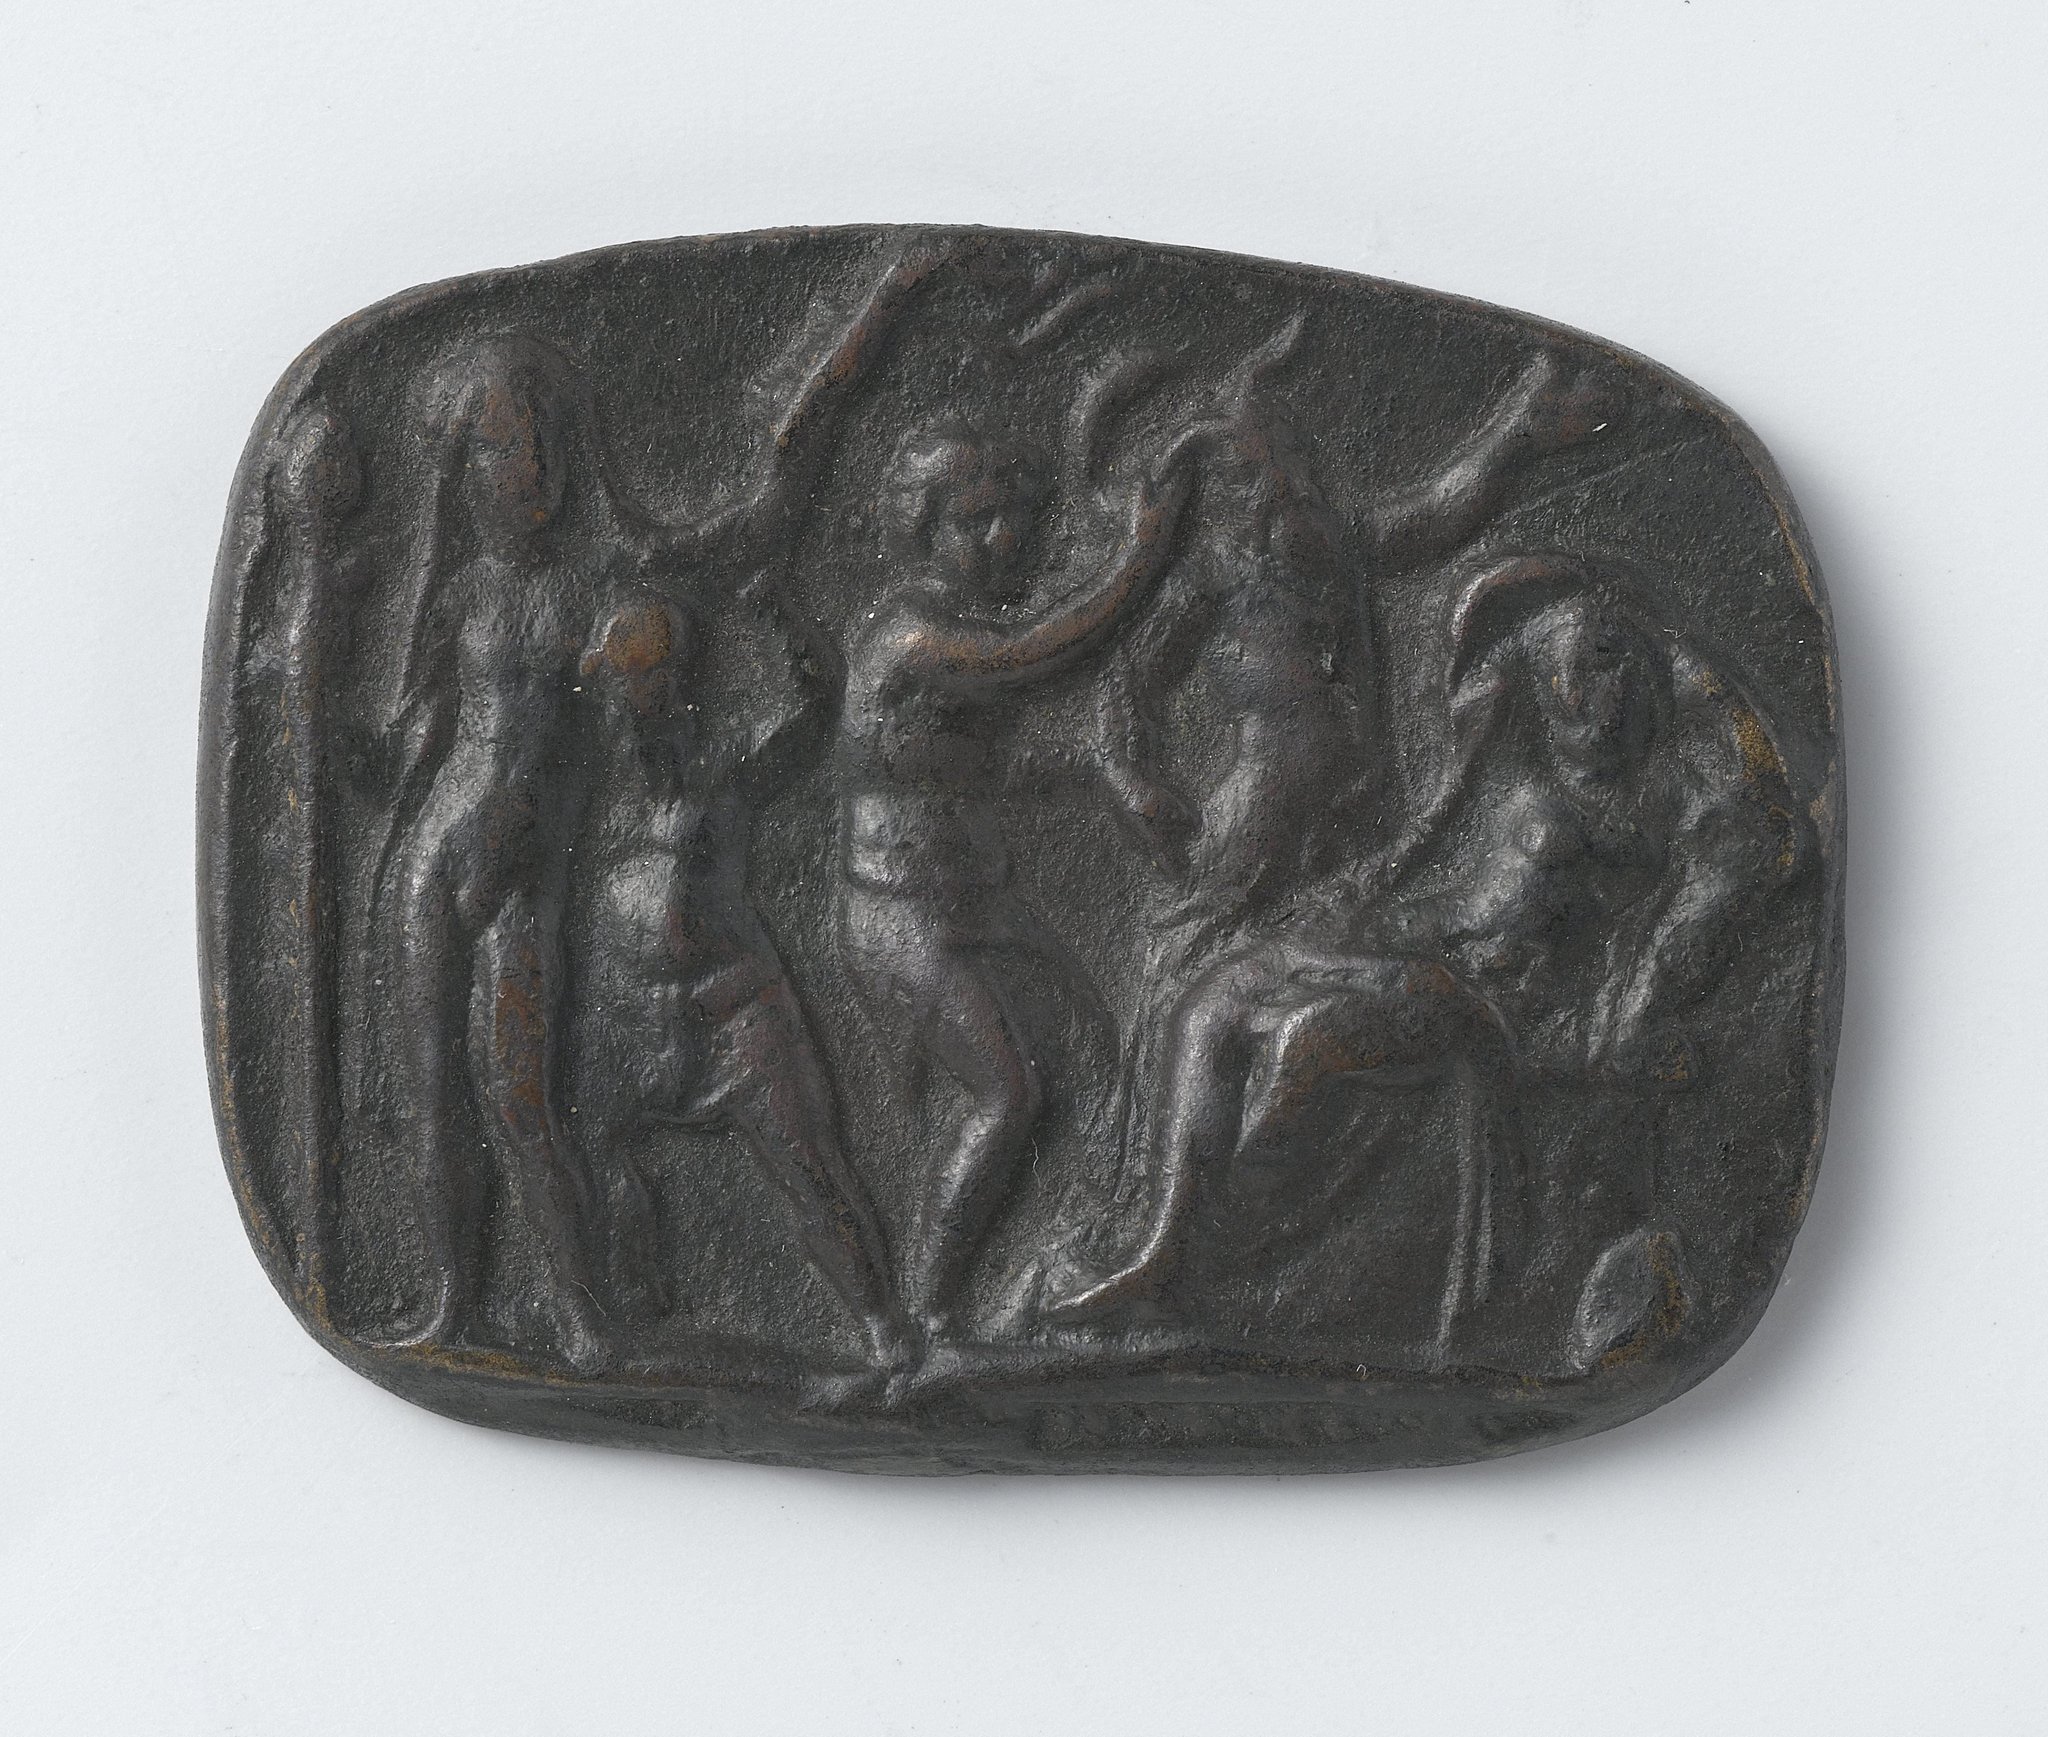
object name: sculpture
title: Bacchus en Ariadne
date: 1474-1500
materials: bronze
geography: italy